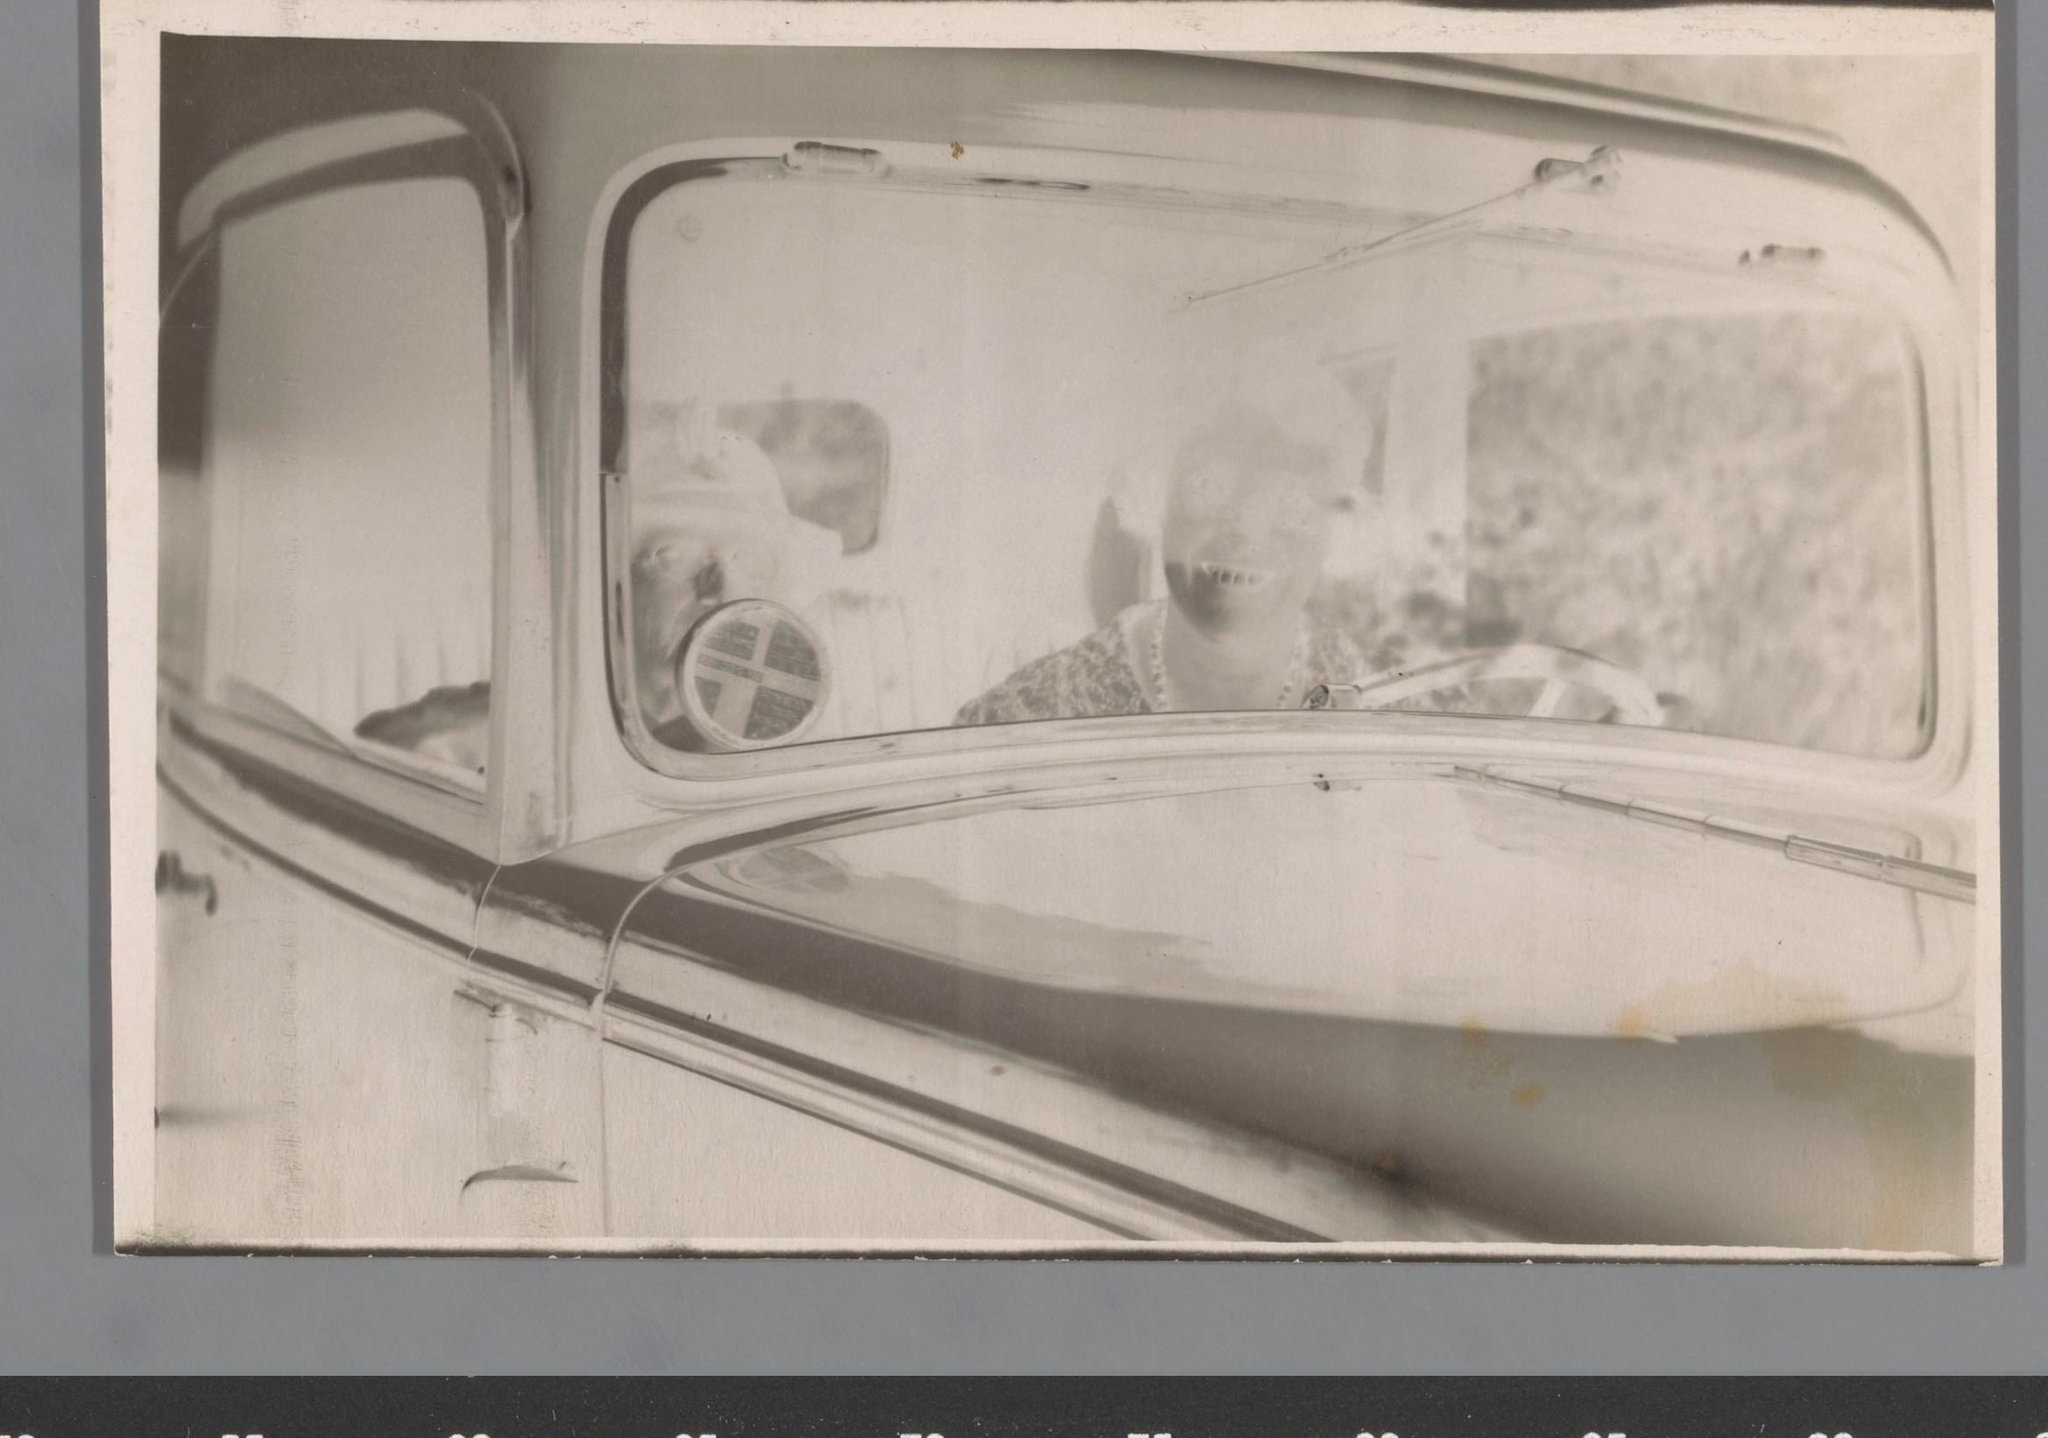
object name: photograph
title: Twee onbekende vrouwen in een auto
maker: Anonymous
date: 1920-1935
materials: photographic support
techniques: gelatin silver print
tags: adult woman, automobile